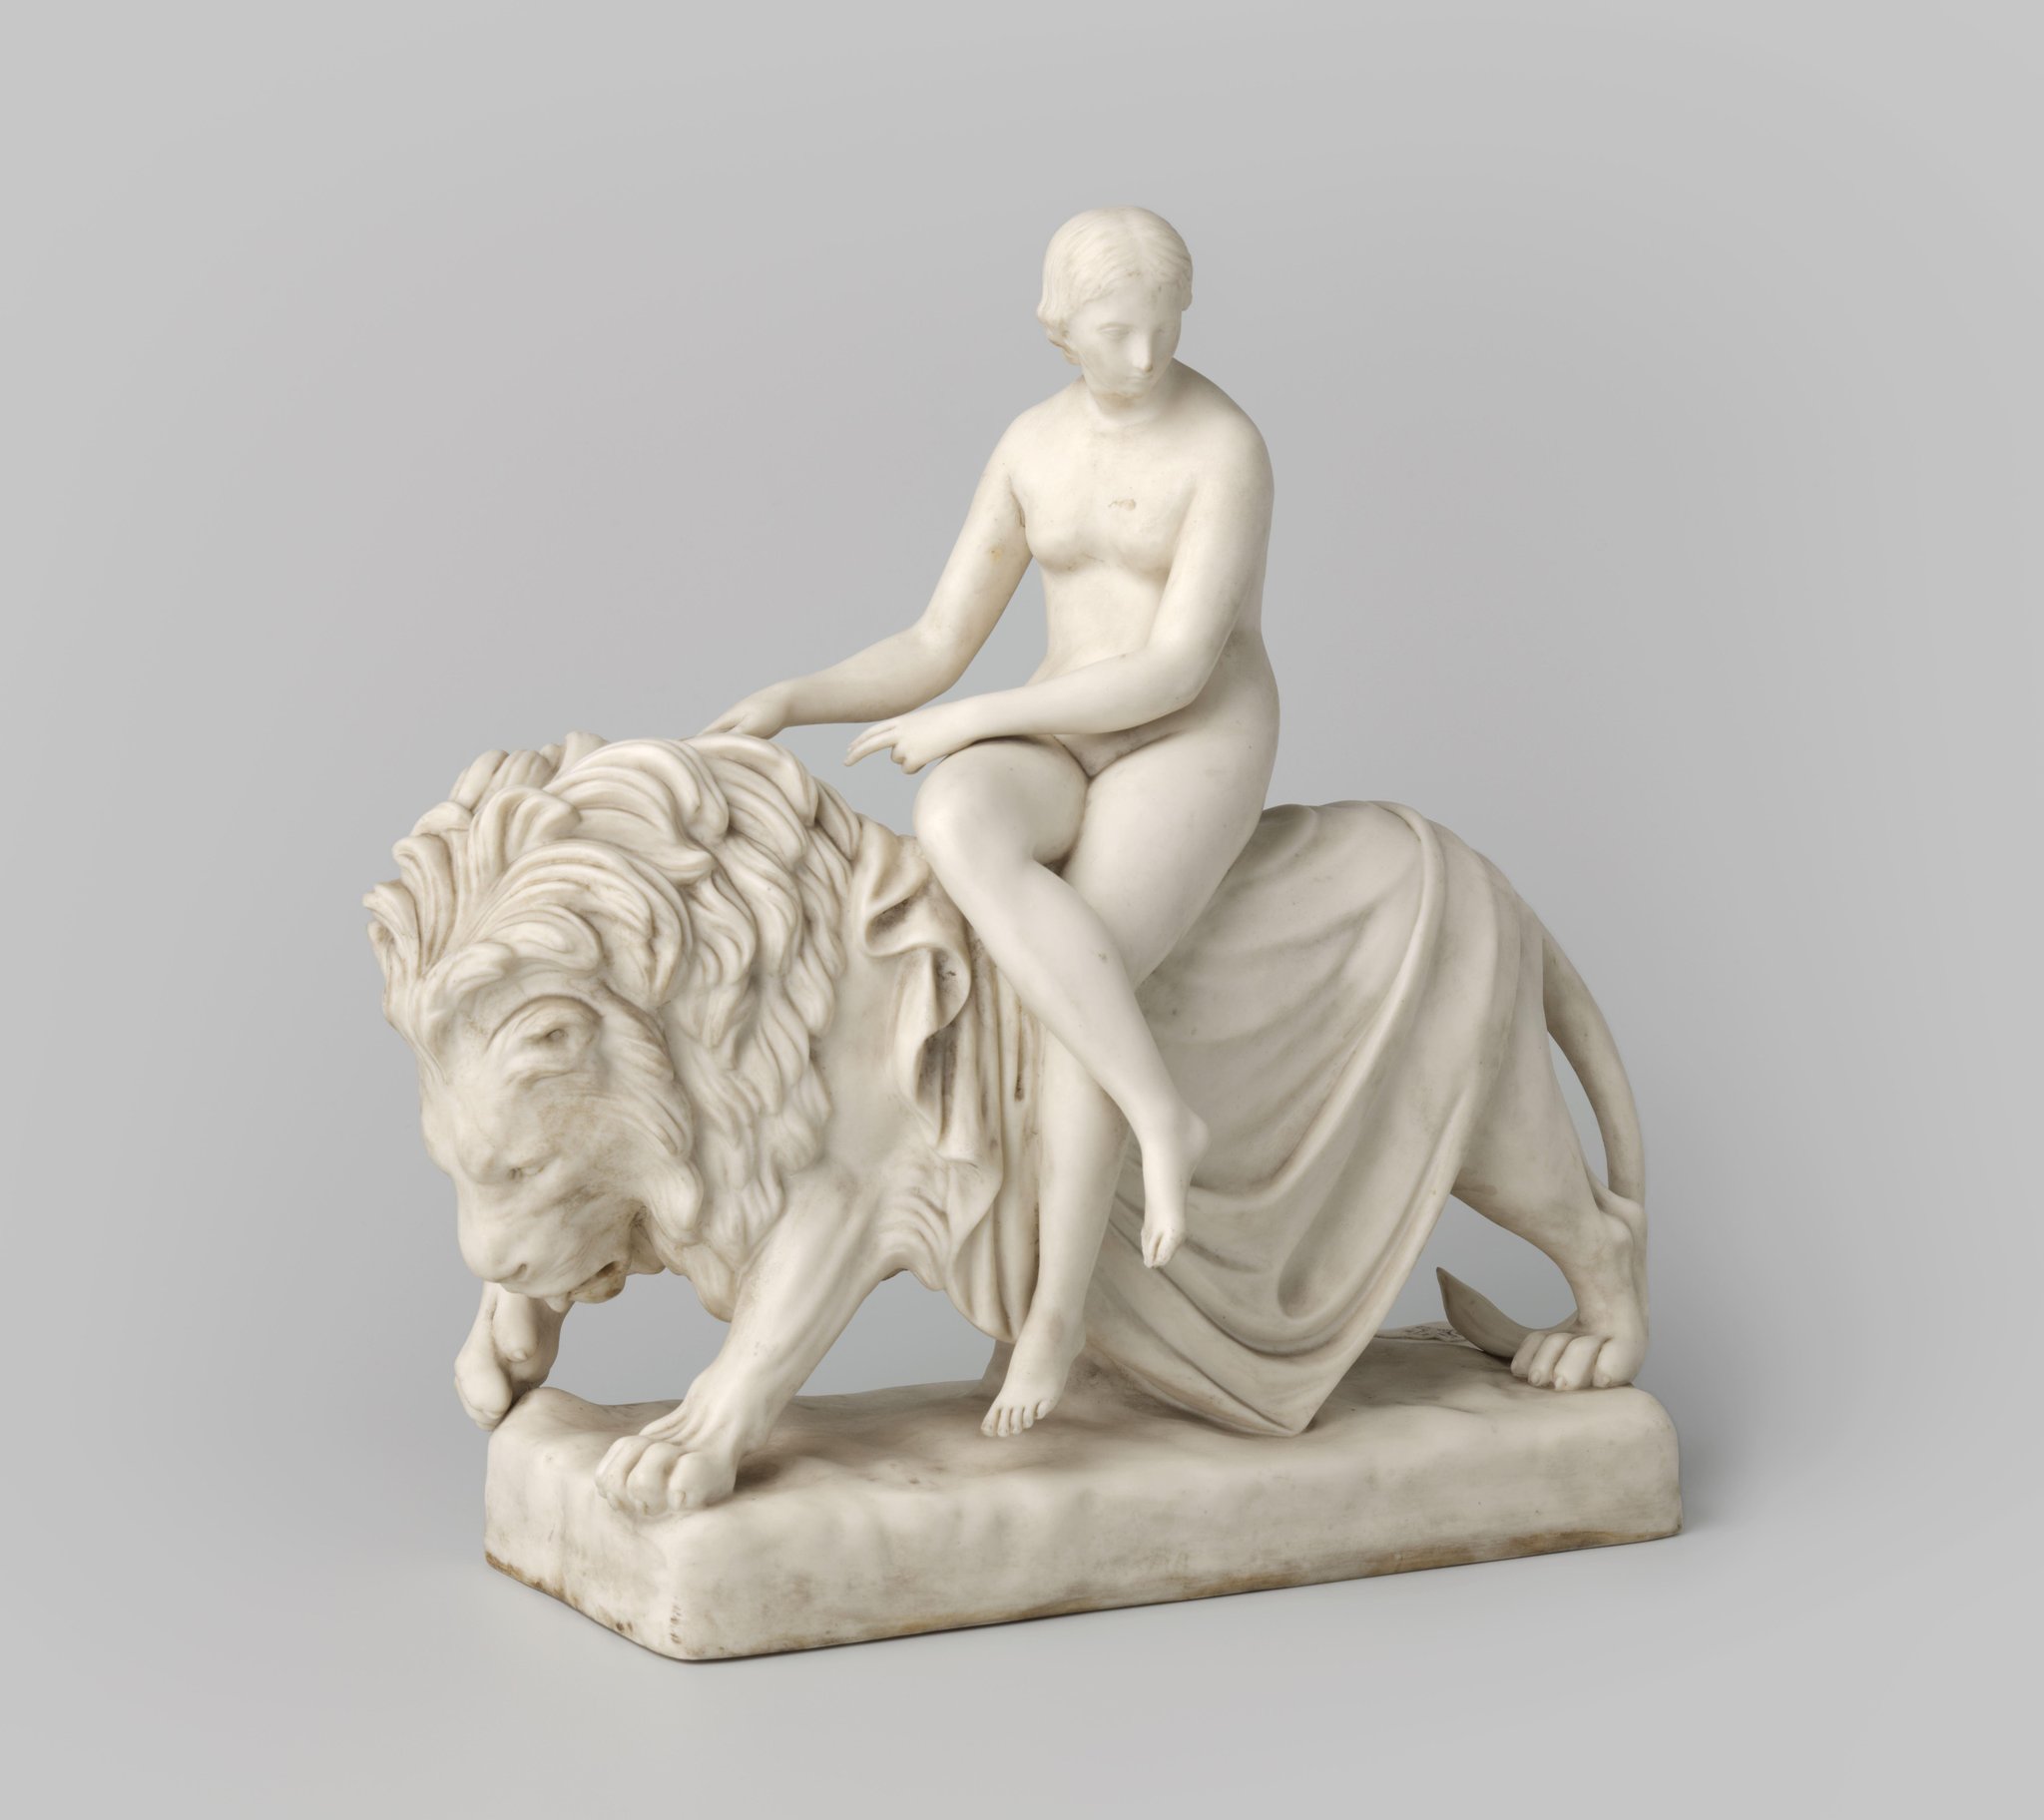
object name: sculpture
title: Leeuw met vrouwenfiguur van marmer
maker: Anonymous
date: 1400-1950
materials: marble